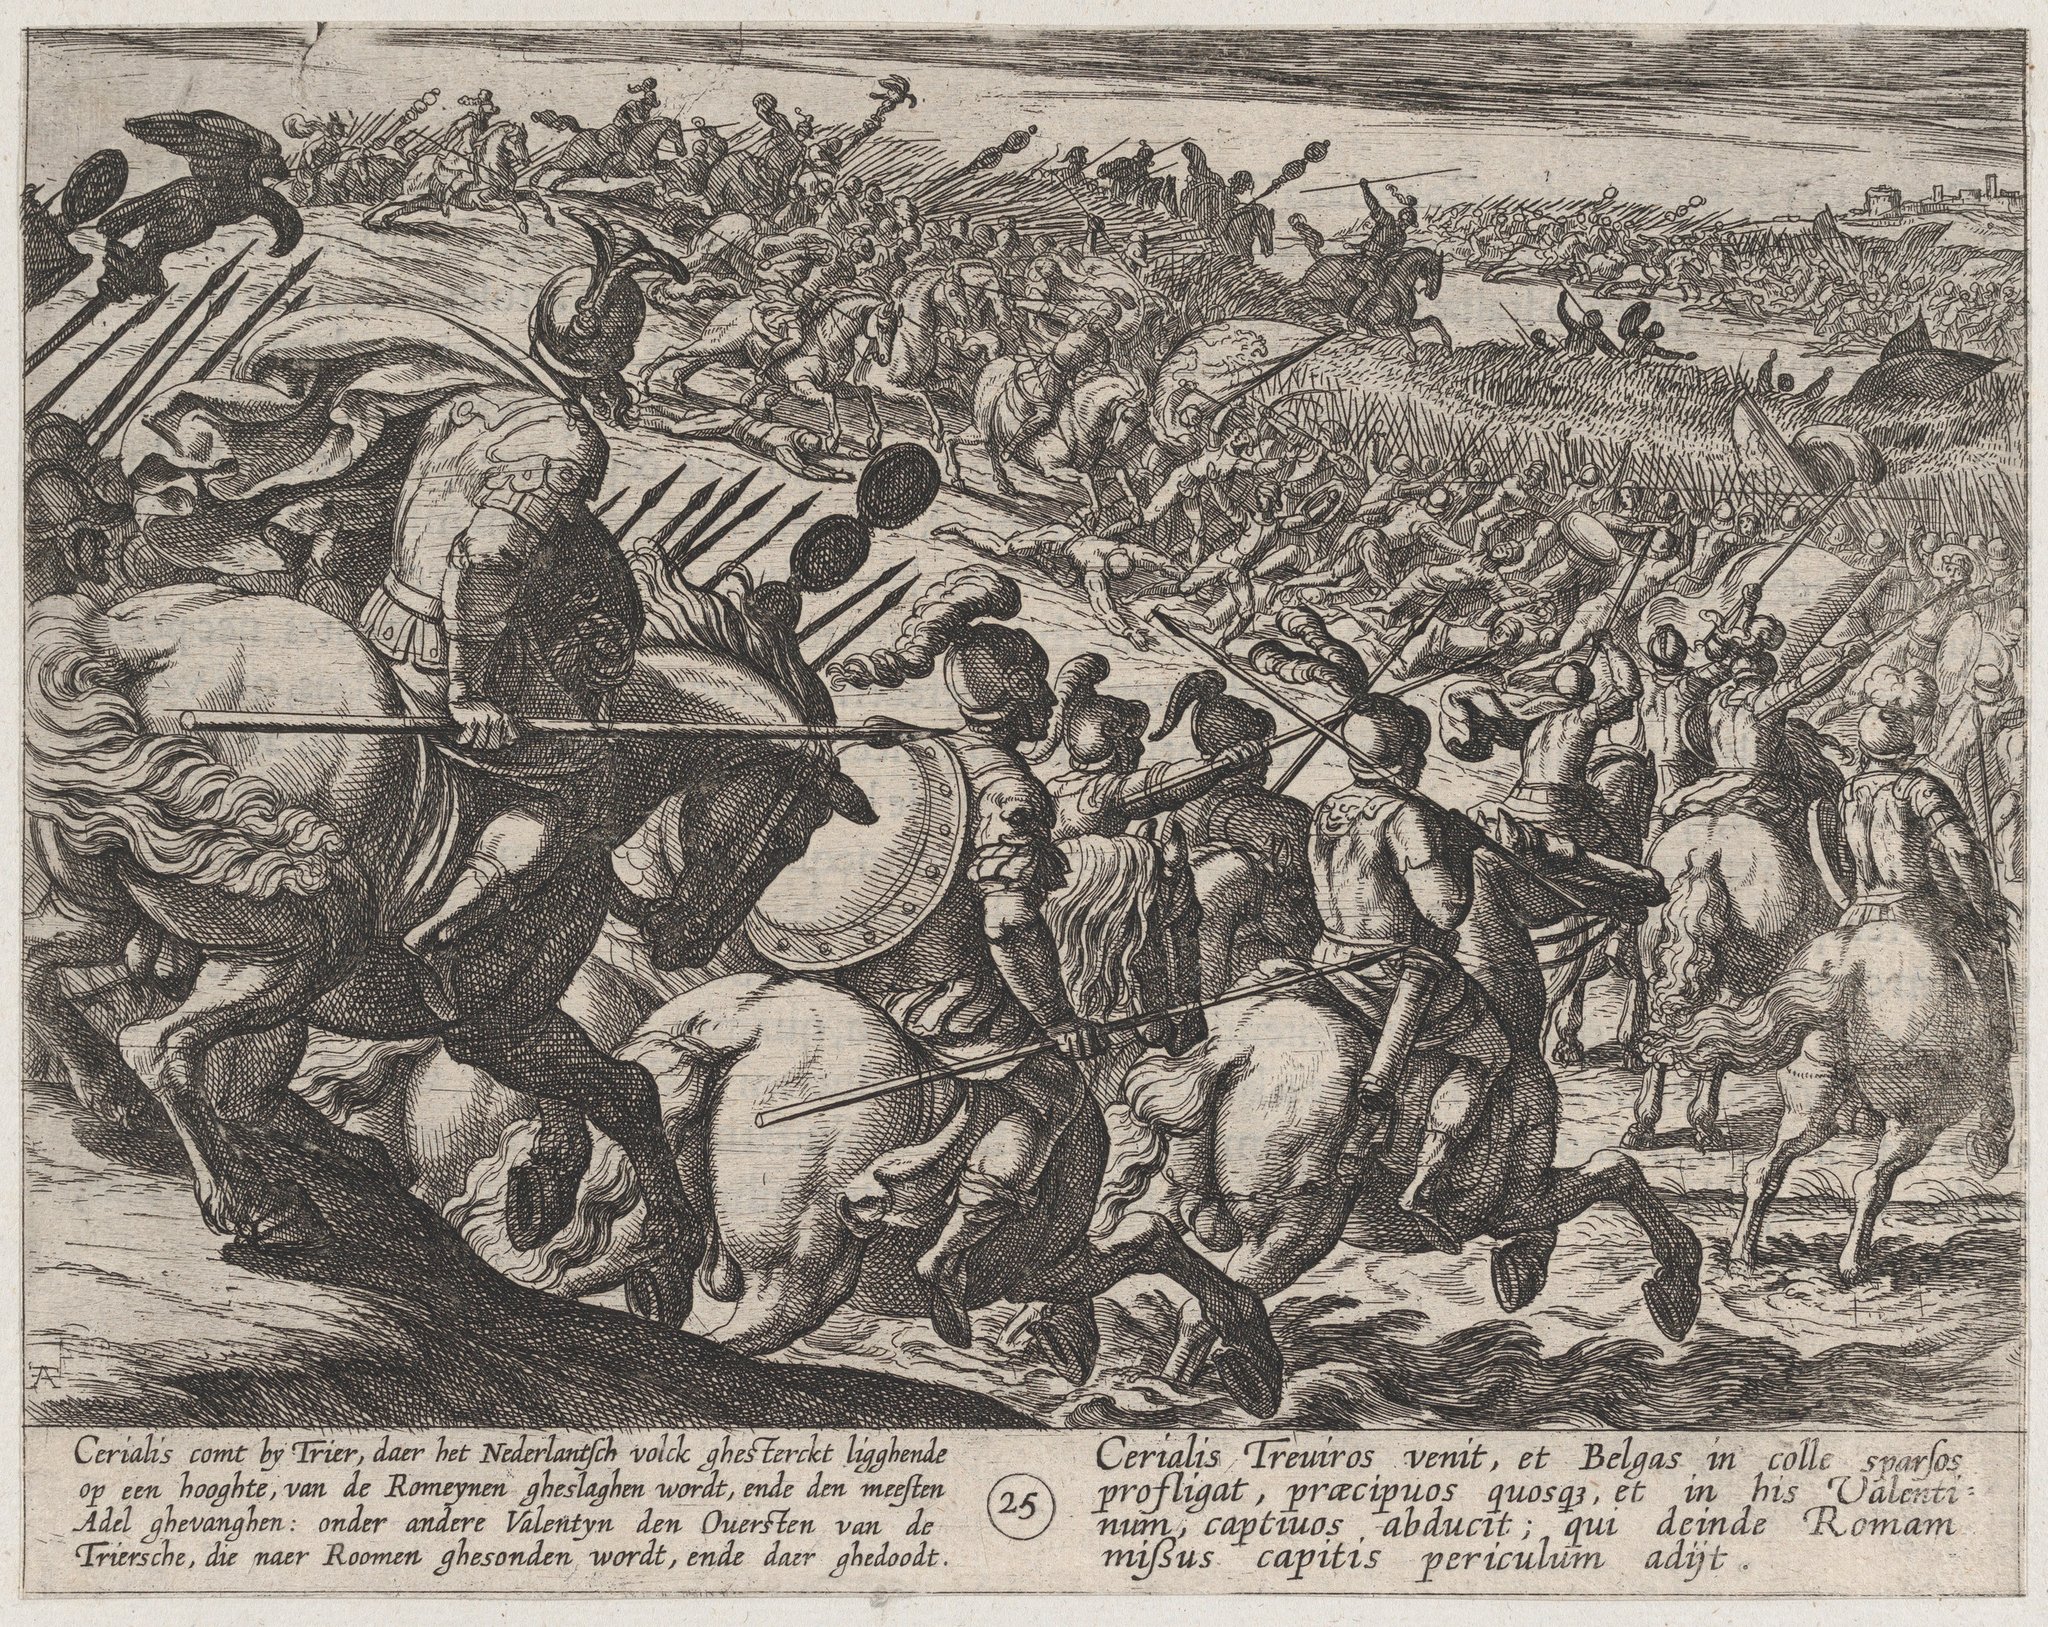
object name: print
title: Plate 25: The Roman Commander Cerialis Attacks Near Trier, from The War of the Romans Against the Batavians (Romanorvm et Batavorvm societas)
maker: antonio tempesta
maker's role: artist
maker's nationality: italian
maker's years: 1555-1630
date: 1611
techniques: etching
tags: wars,soldiers,men,horses